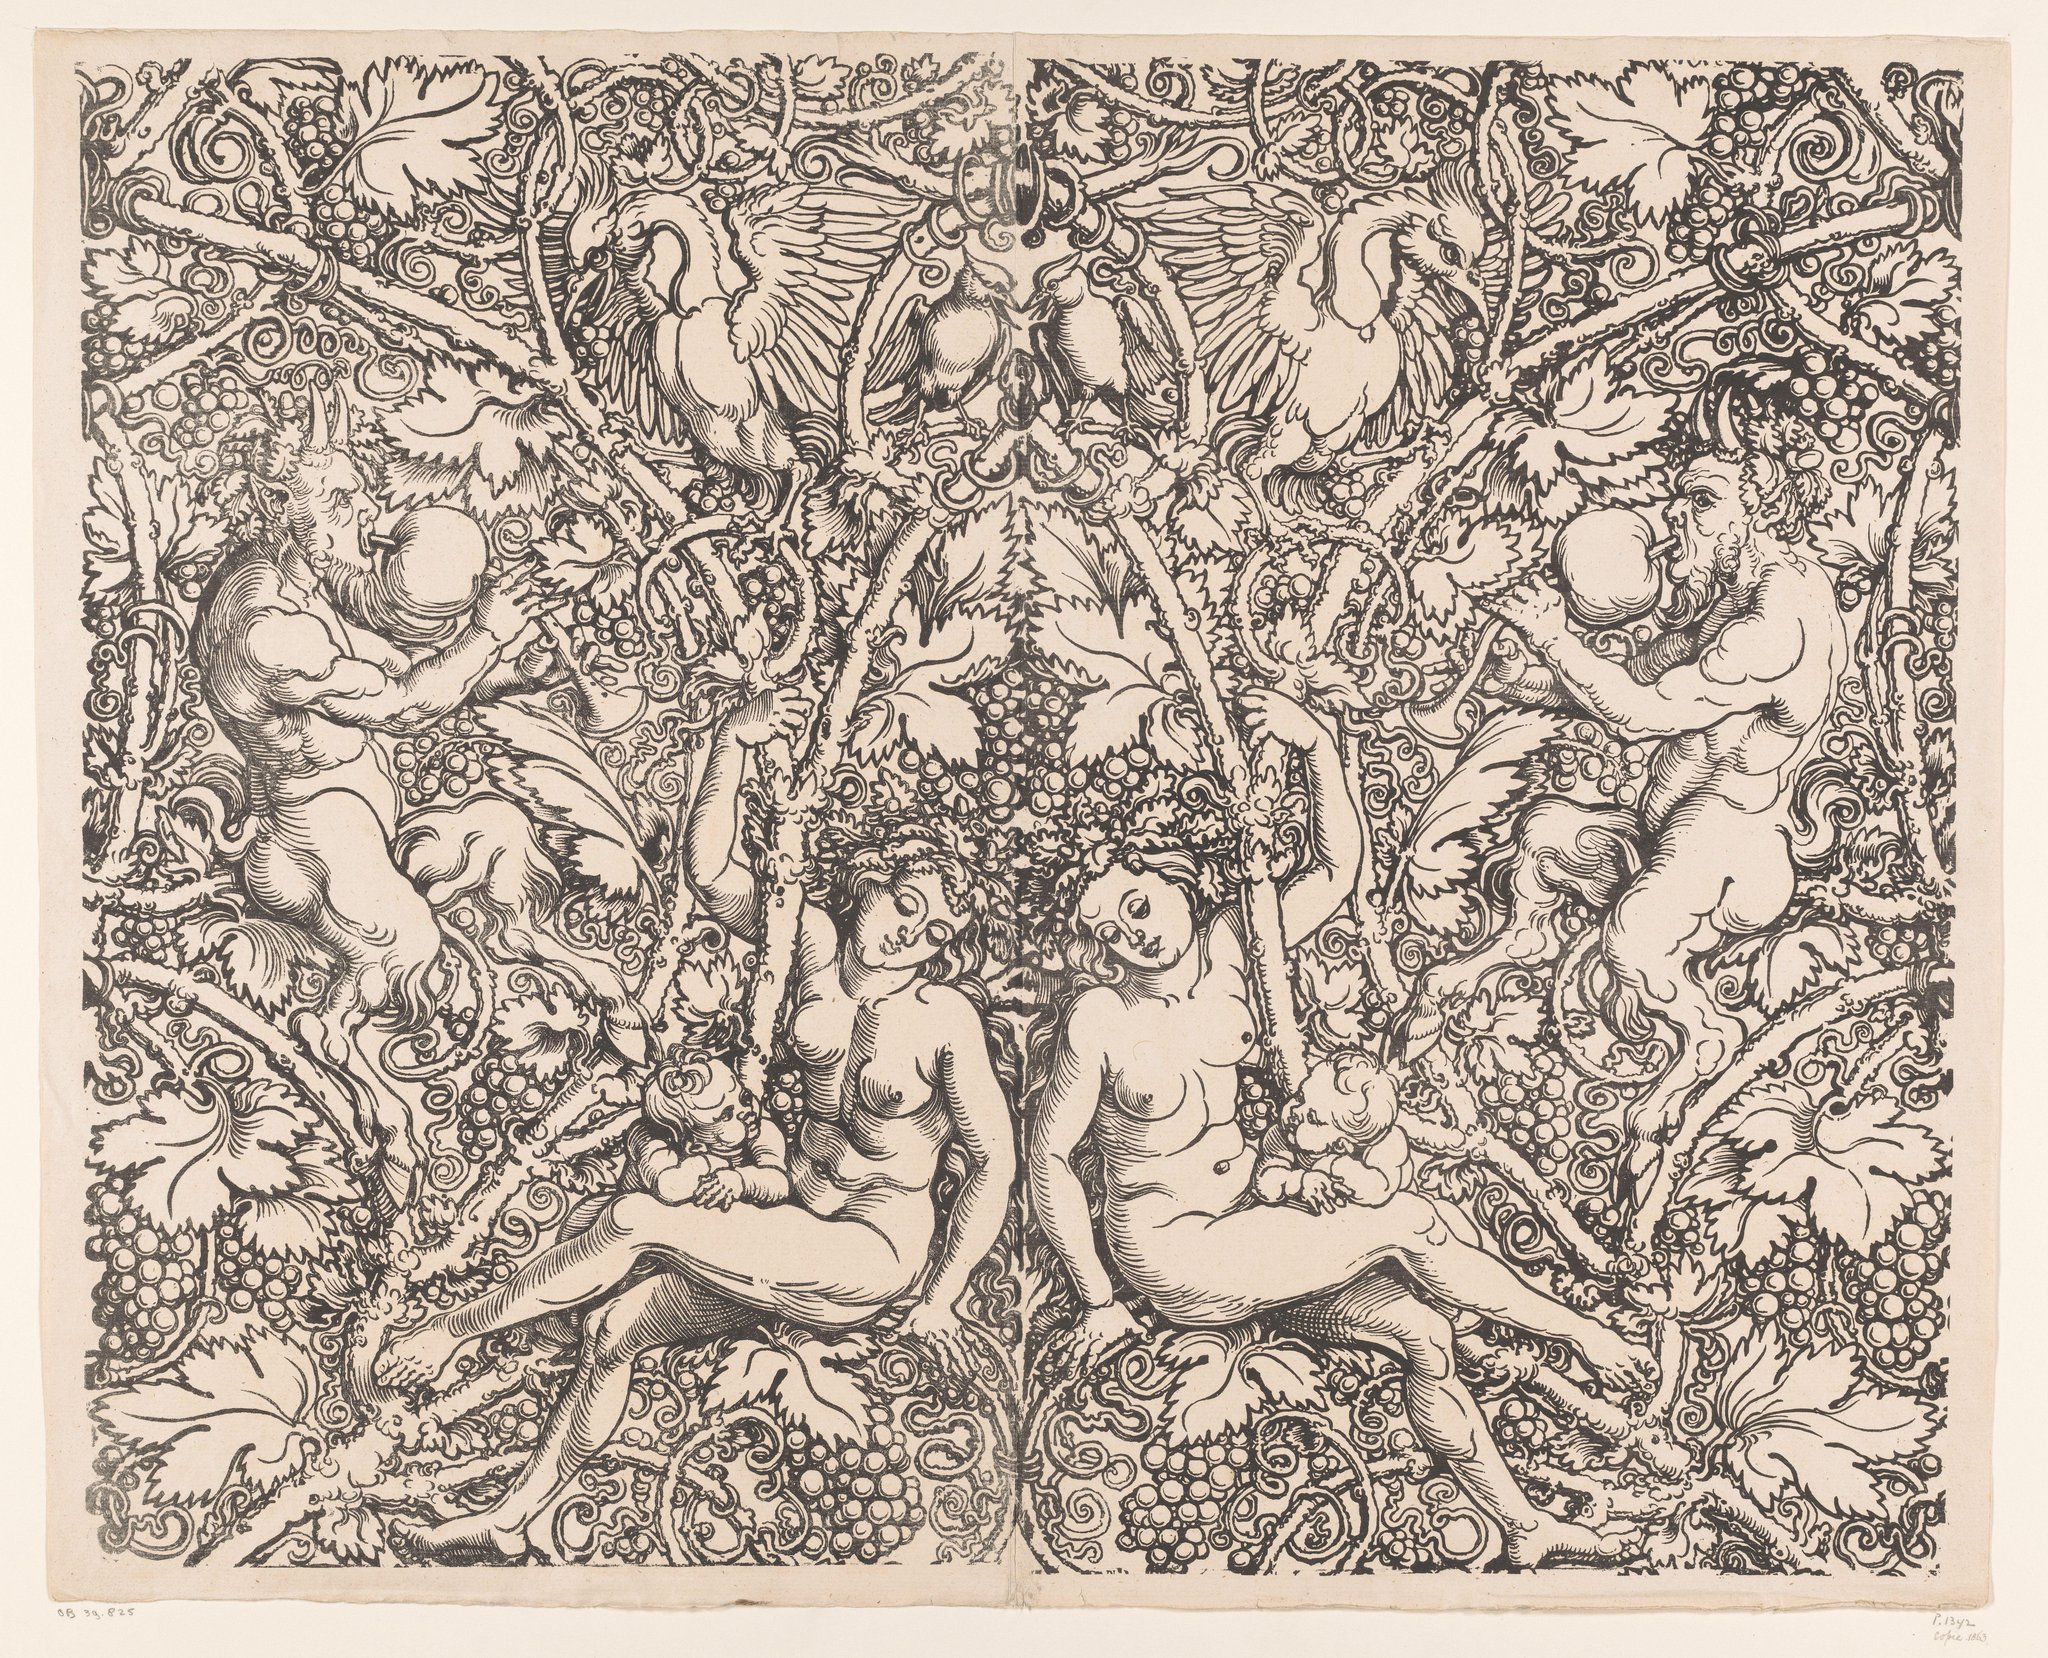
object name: print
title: Satyrfamilie tussen wijnranken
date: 1510-1550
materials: paper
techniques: woodcut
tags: attributes of bacchus: vine, satyr(s) (in general), tapestry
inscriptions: collector's mark: Lugt 2228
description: Ontwerp voor wandtapijt bestaande uit twee gespiegelde, maar niet identieke, delen. Deze zijn hier aan elkaar geplakt.